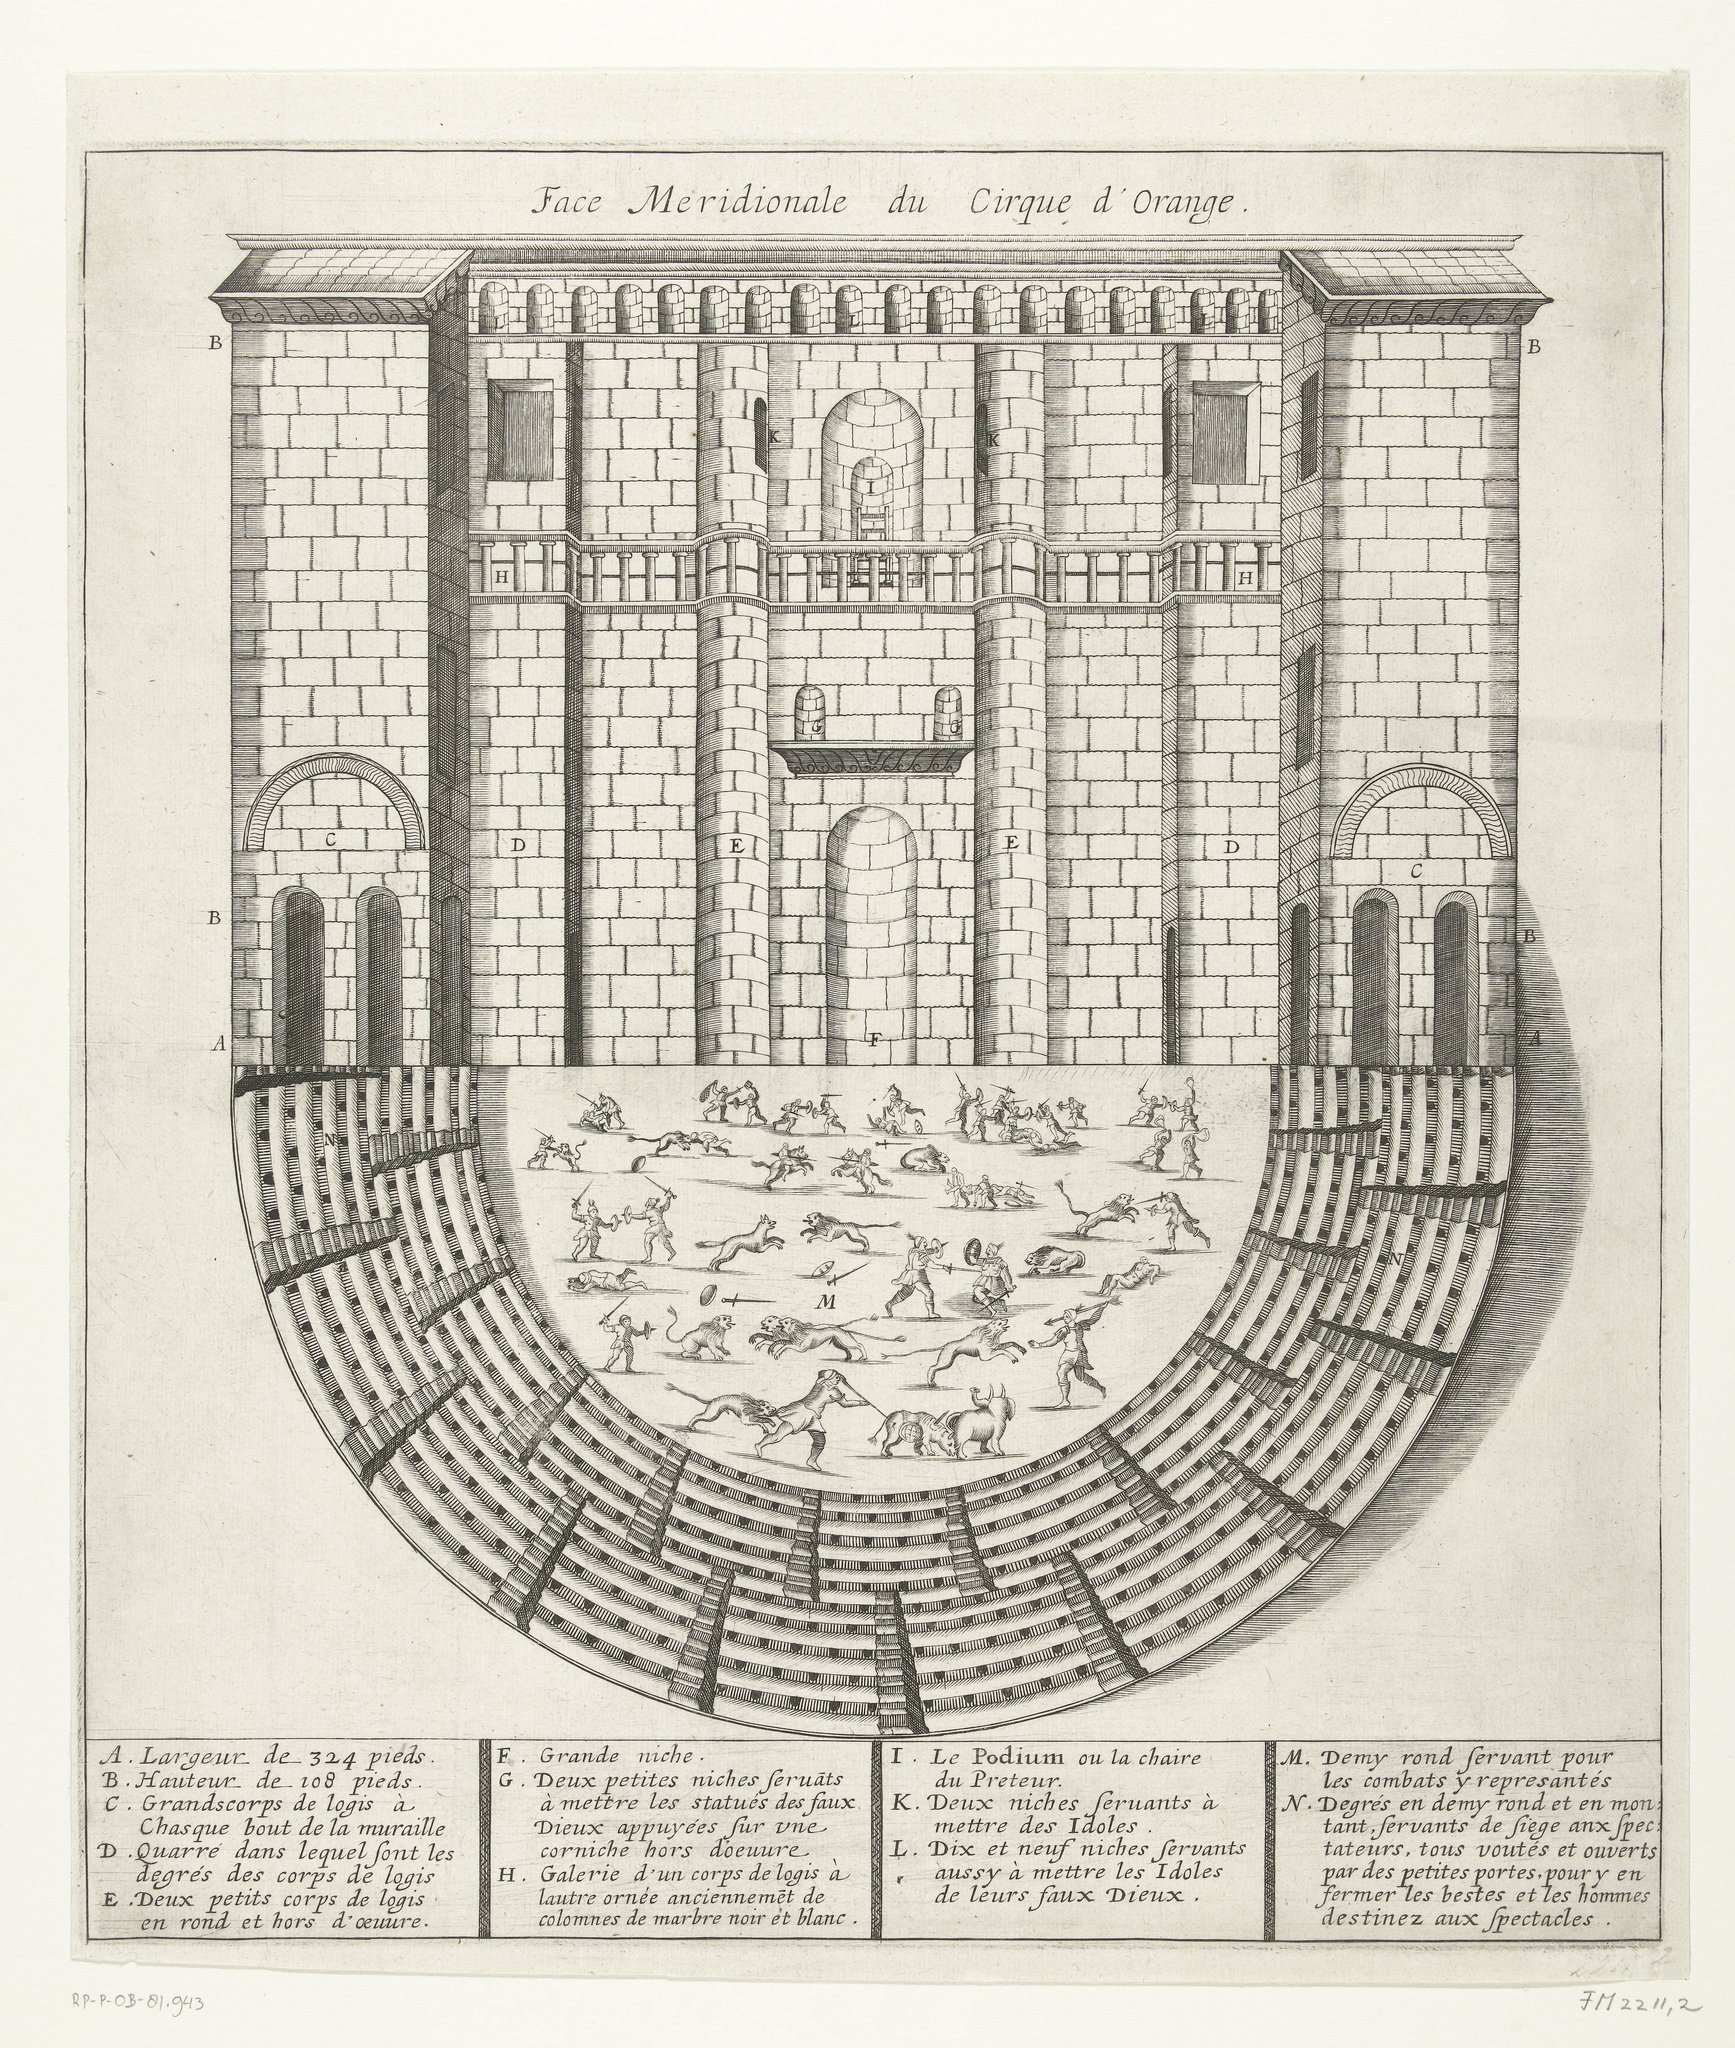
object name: print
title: Face Meridionale du Cirque d'Orange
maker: j. baugin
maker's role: print maker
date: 1637-1640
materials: paper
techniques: engraving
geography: france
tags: theatre (building)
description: Gebruikt als illustratie in: Joseph de la Pisé, Tableau de l'histoire des princes et principauté d'Orange, Den Haag, 1639-1640.